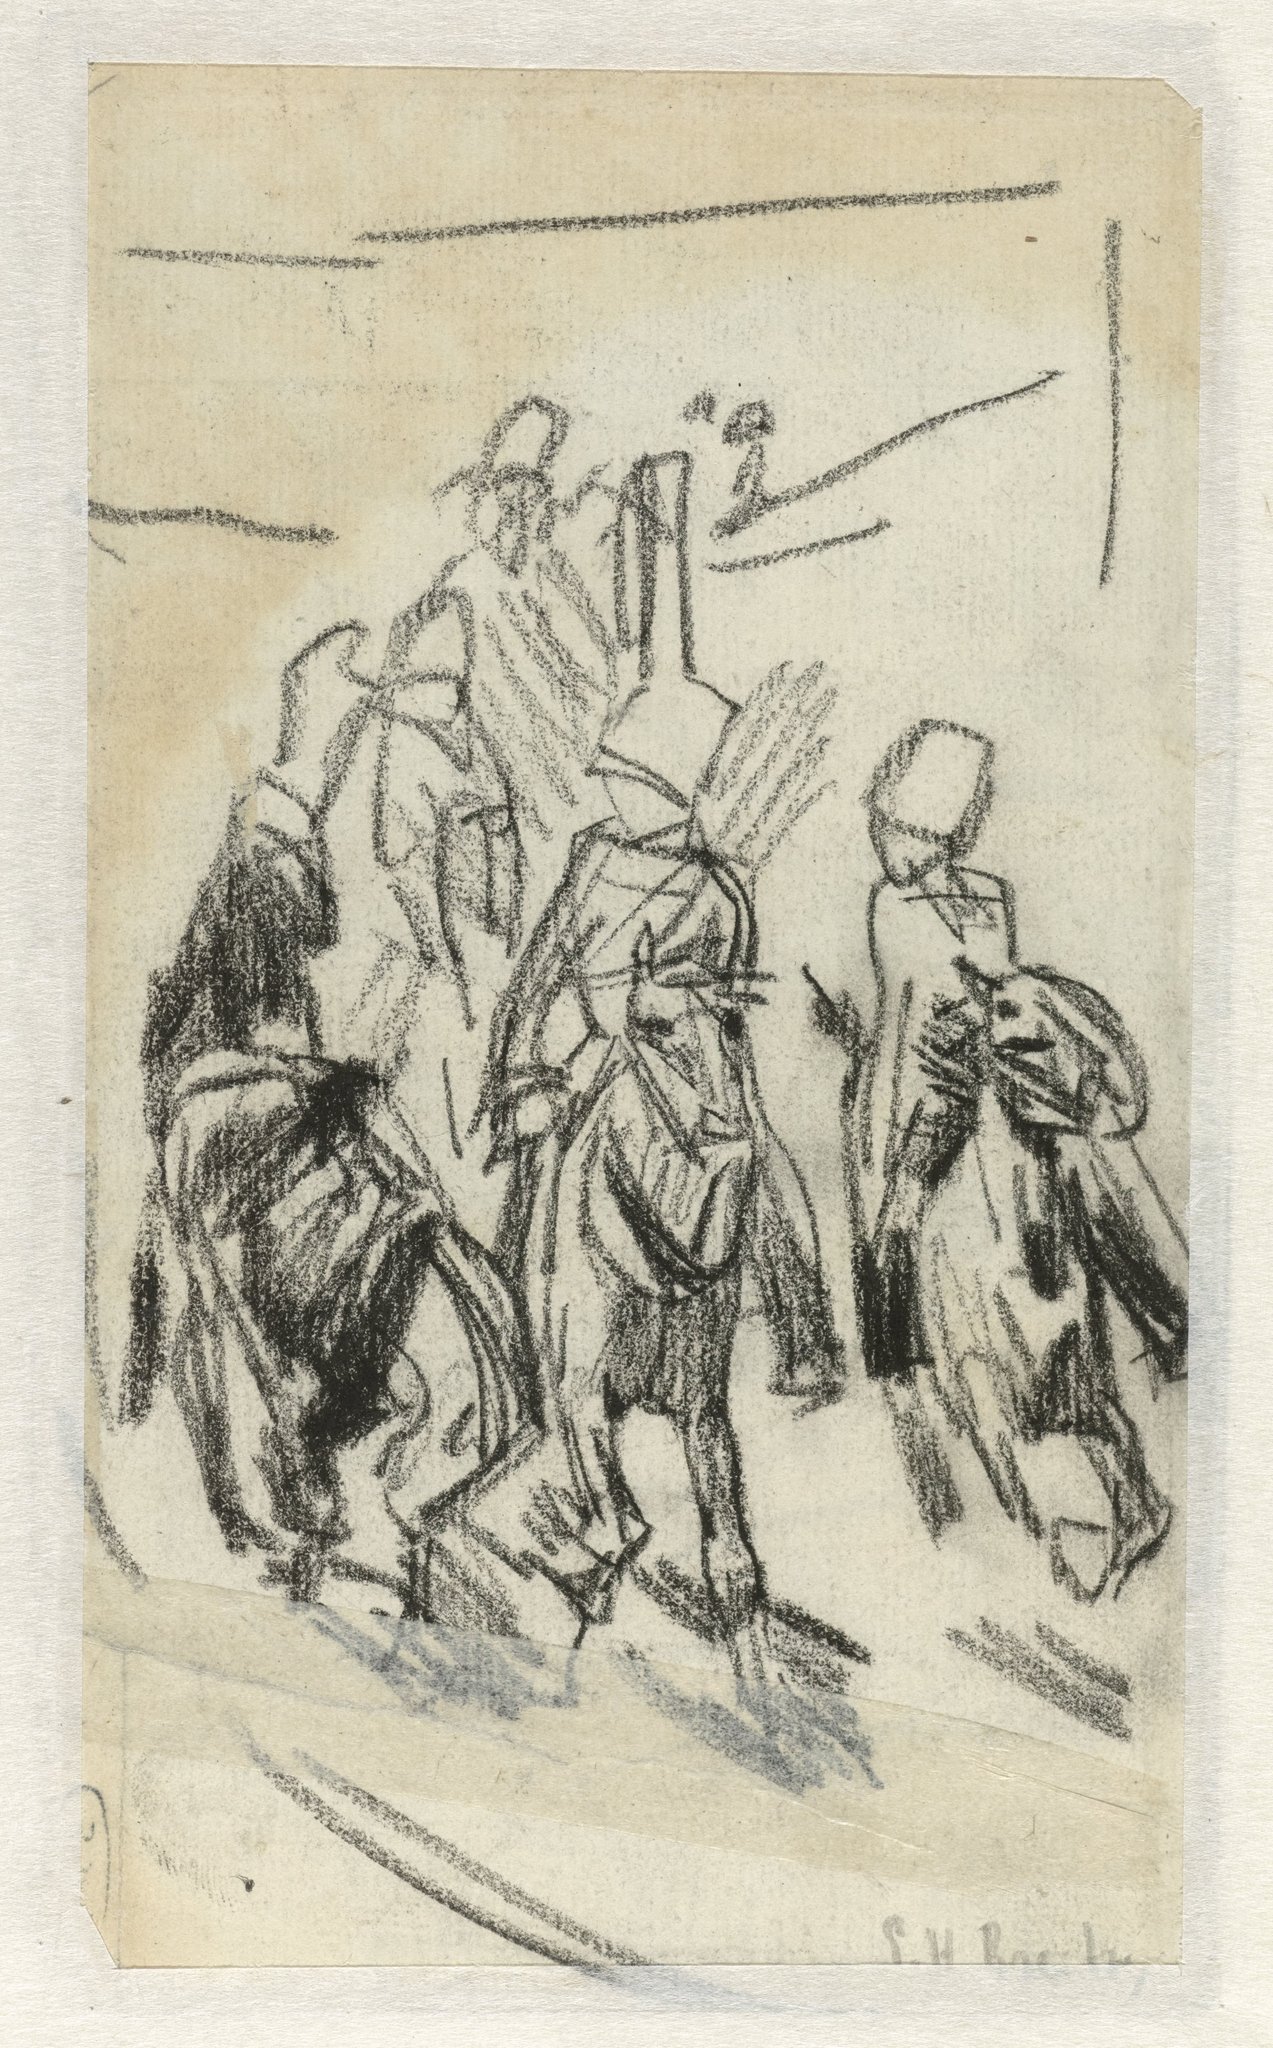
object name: drawing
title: Voorstudie voor De Gele Rijders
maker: george hendrik breitner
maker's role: draughtsman, painter, print maker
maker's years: 1857-1923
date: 1885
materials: chalk, paper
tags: land forces (+ cavalry, horsemen)